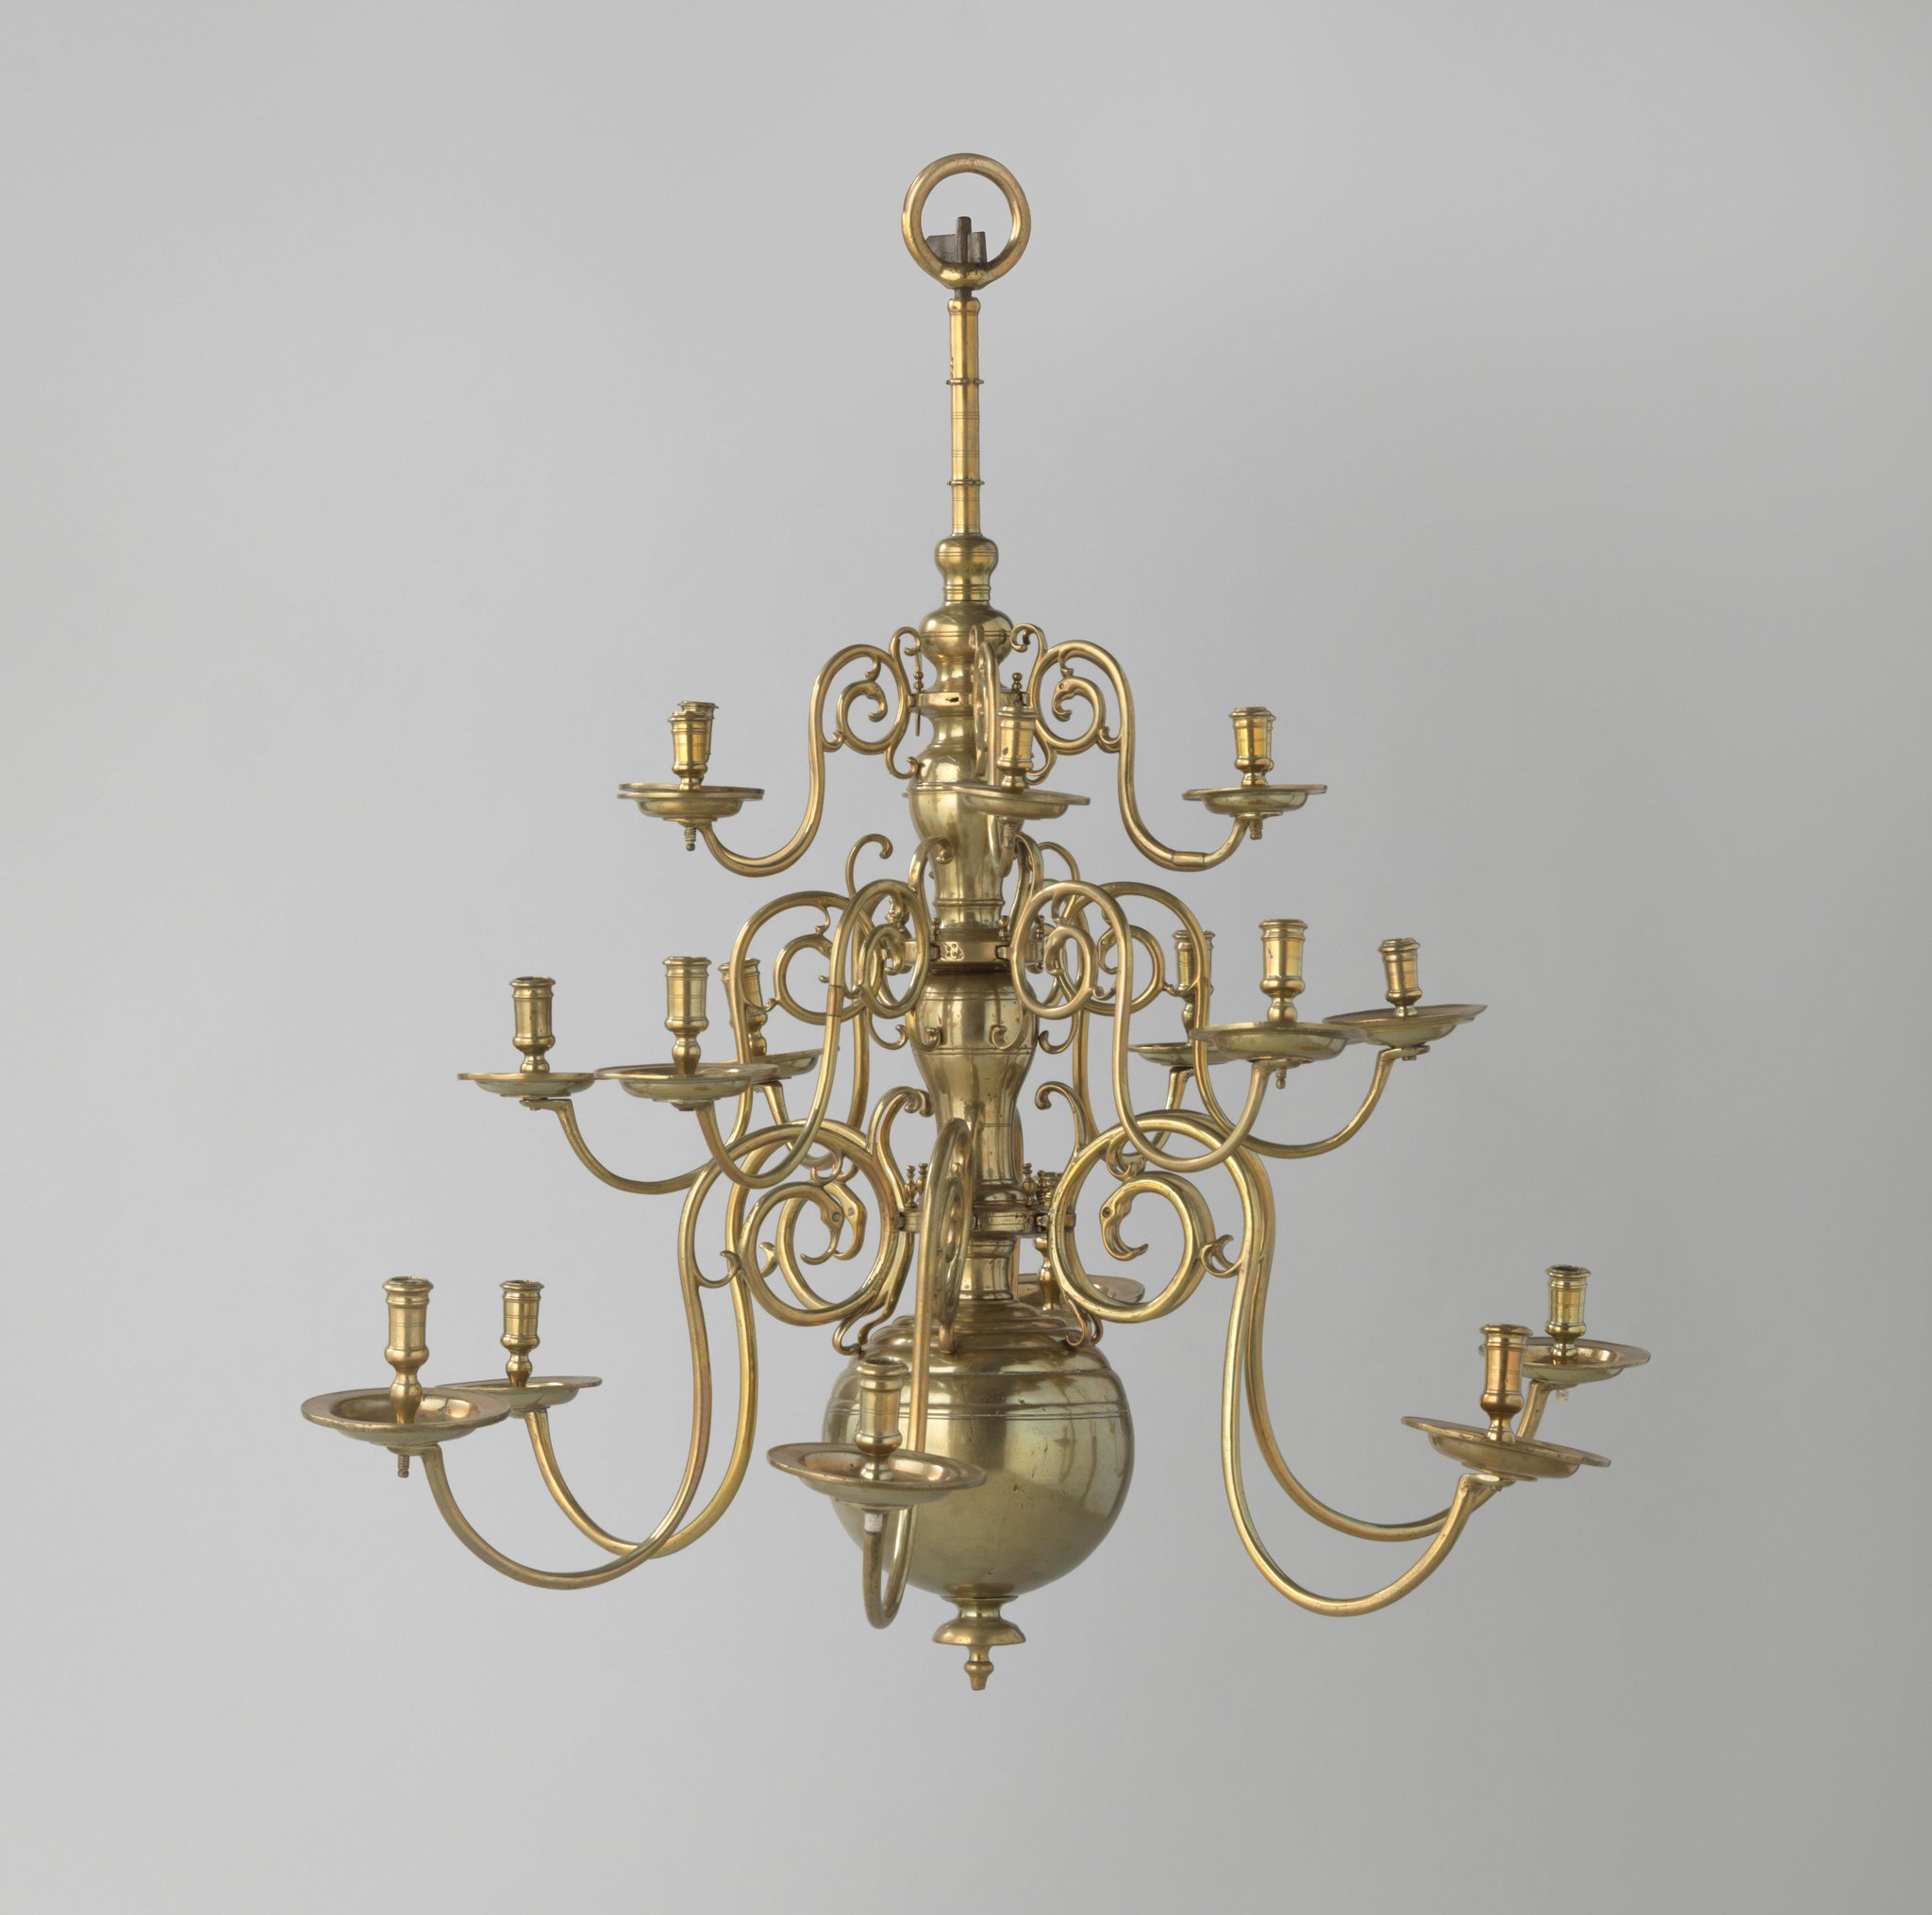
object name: chandelier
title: Arm met kaarsenhouder van kaarsenkroon van drie hoogten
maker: Anonymous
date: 1675-1725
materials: brass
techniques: casting, screwed, turning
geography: southern netherlands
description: Kaarsenarm behorende bij een messing kaarsenkroon van drie hoogten. De S-vormige arm heeft een krul en gaat naar buiten toe over in het platte verdikking met een schroefgat. Daarin is de kaarsenhouder met de vetvanger vastgezet. De vetvanger is aan de onderzijde geribd geprofileerd rond de opening en heeft verder een maal twee gegroefde ringen en een enkele gegroefde ring. De cylindrische kaarsenhouder, die een geprofileerde uitstekende rand, twee gegroefde ringen en een verdikking onderaan heeft, gaat over in een baluster met onderaan het eind met schroefdraad en een knopje, waarin het centergat te zien is. Dit is de tweede arm van de onderste standring, ongenummerd. De pin, om de arm aan de standring te bevestigen, heeft een balustervorm.